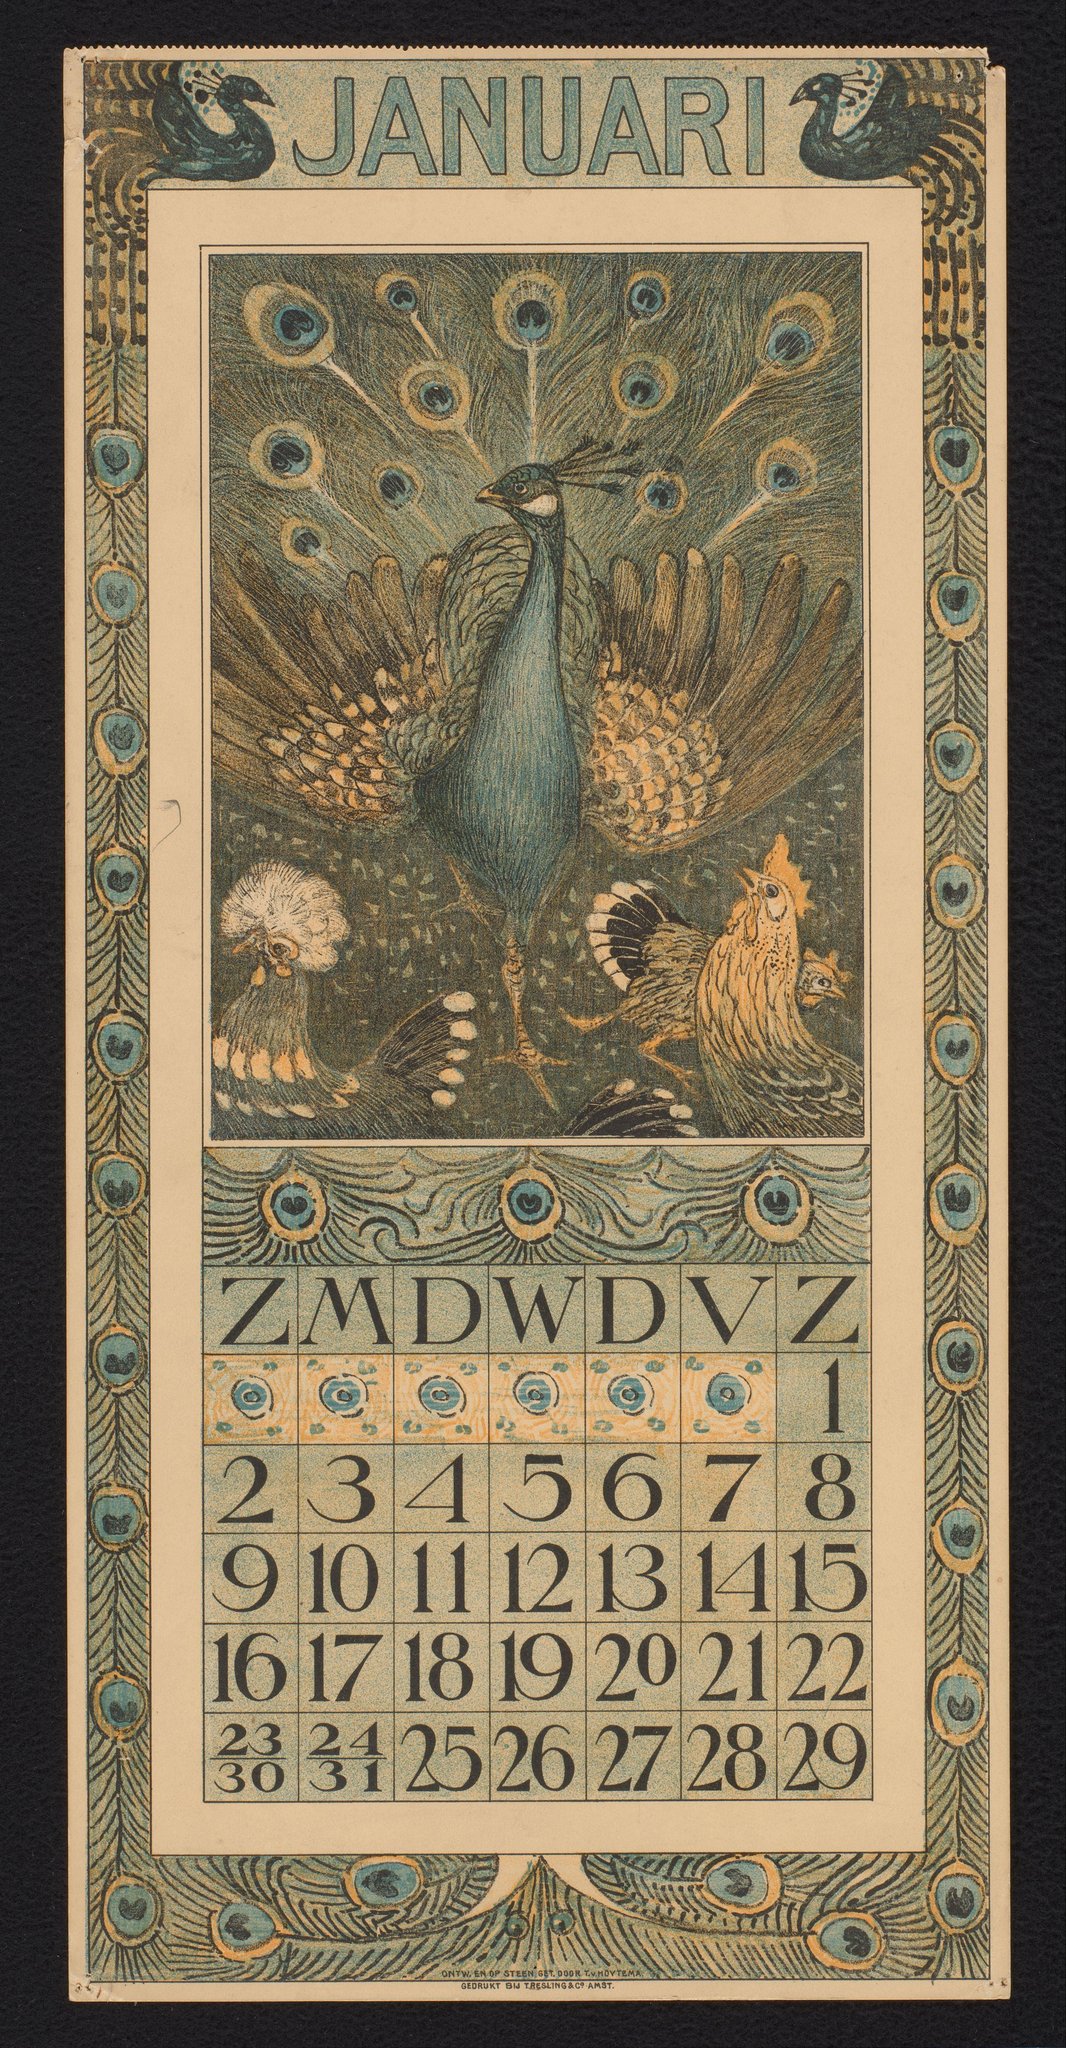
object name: print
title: Kalenderblad voor januari 1910 met pauw en hoenders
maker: theo van hoytema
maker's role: draughtsman, painter, print maker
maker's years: 1863-1917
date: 1909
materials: paper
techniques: lithograph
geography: amsterdam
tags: calendar, almanac, ornamental birds: peacock, fowl (cock, hen, chicken, etc.)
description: Randdecoratie van pauwen en pauwenveren.